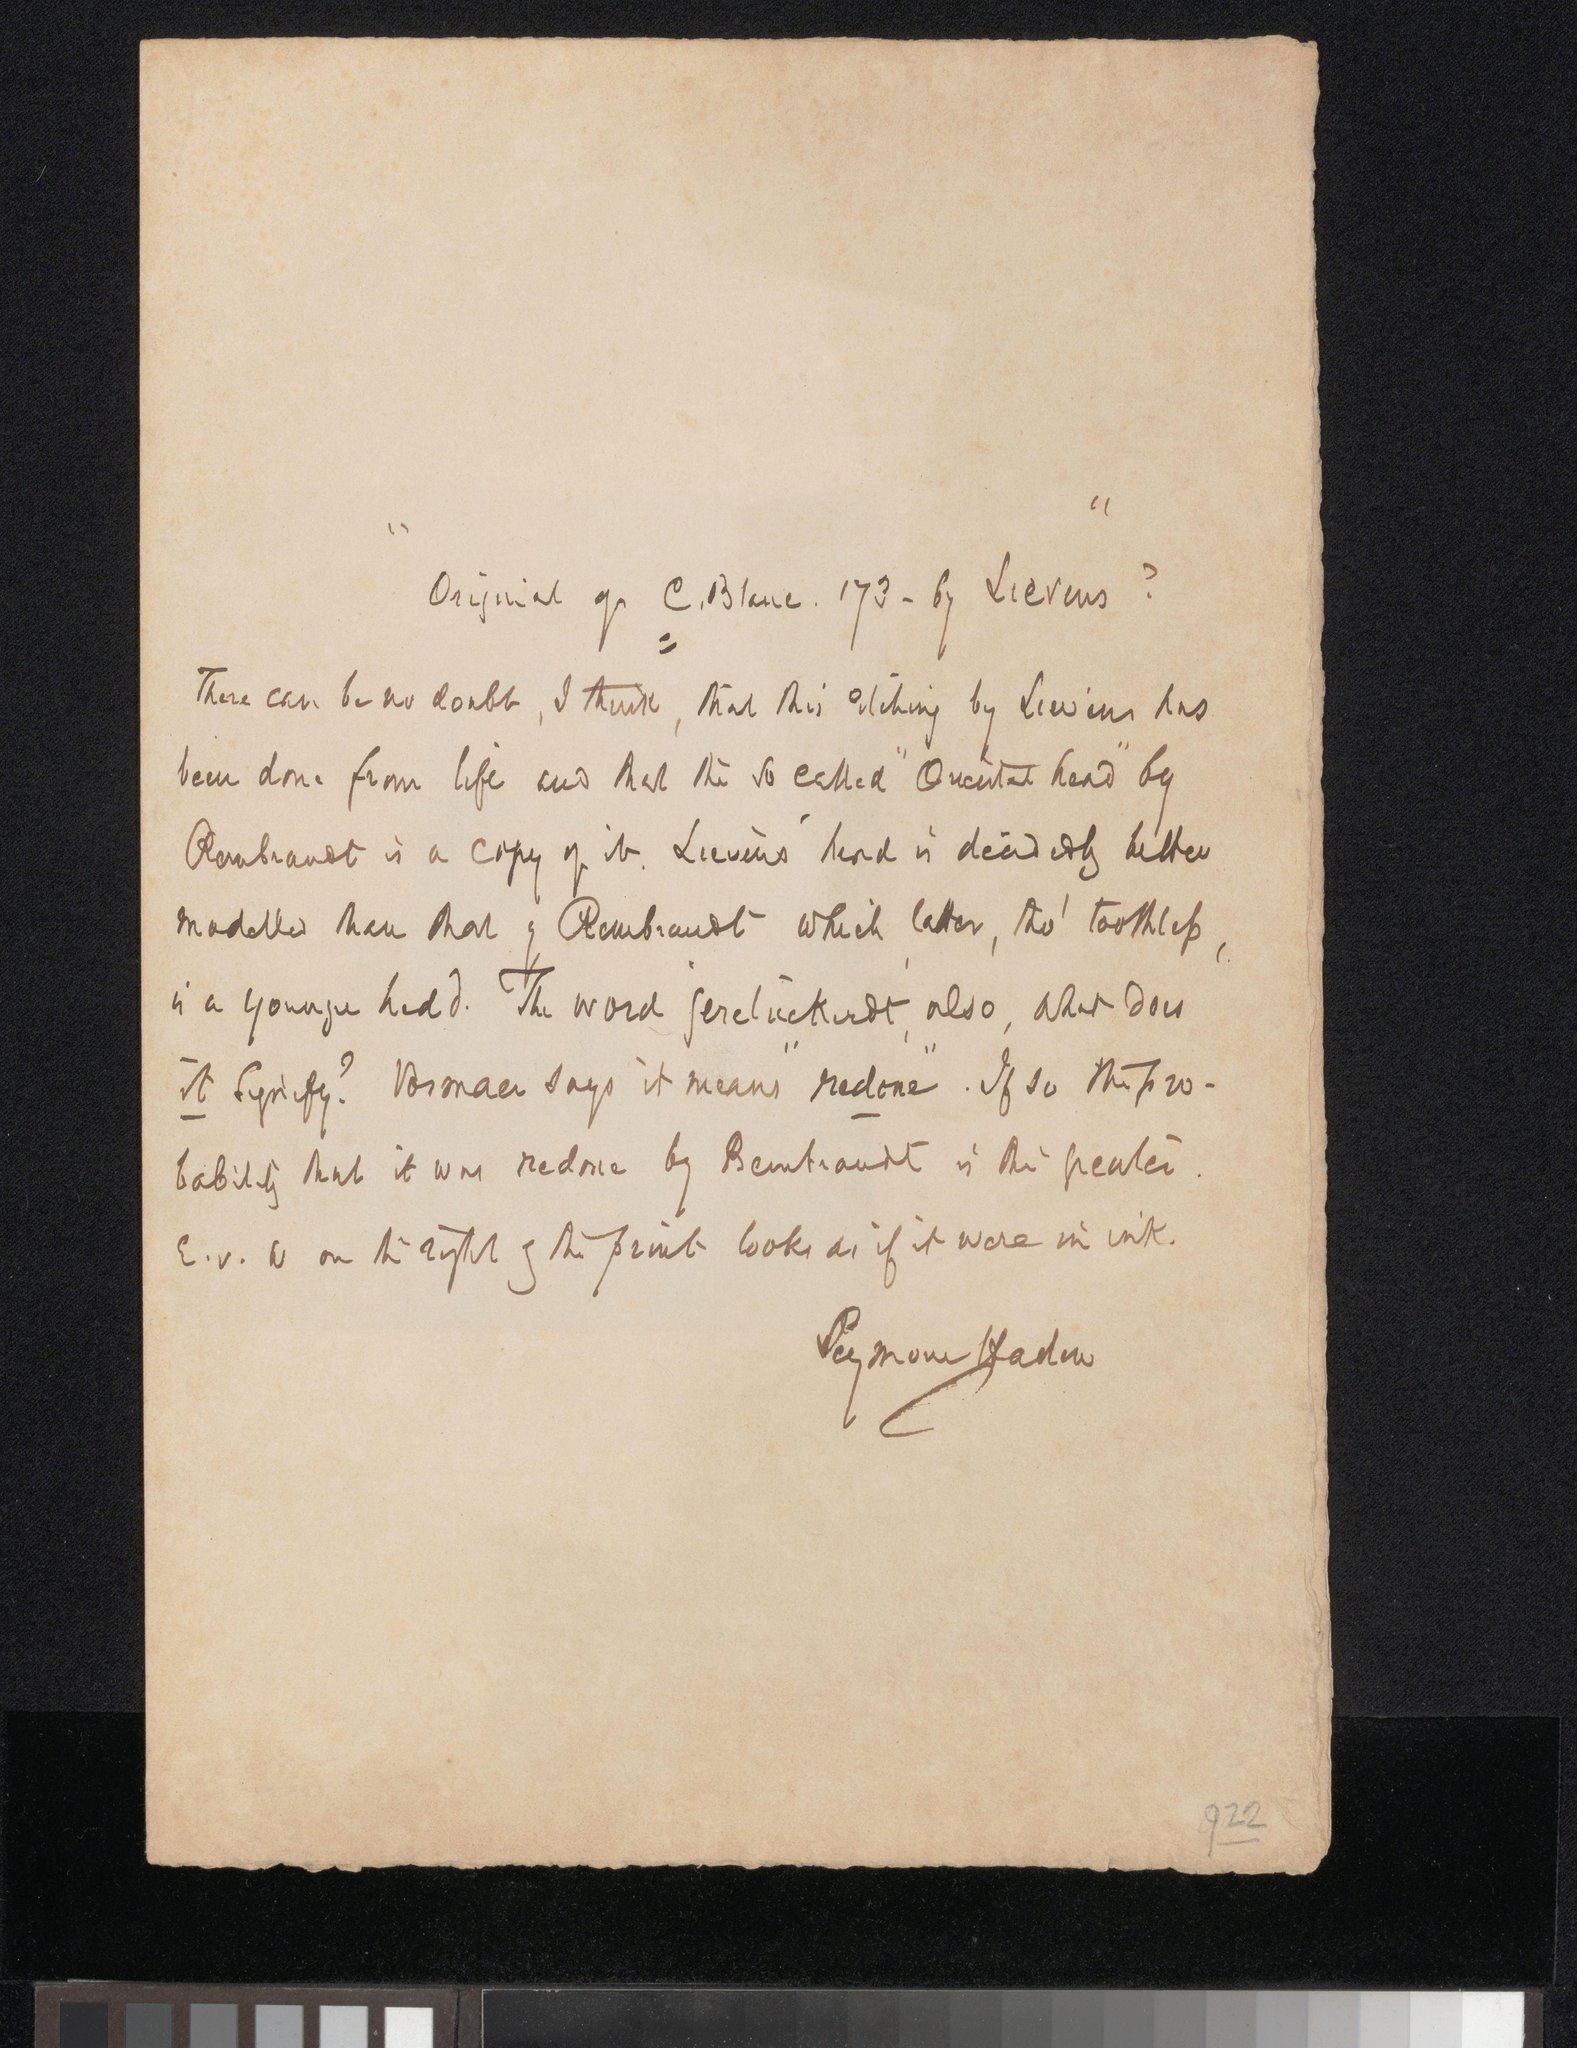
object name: aantekening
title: Aantekening betreffende een ets van Jan Lievens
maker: francis seymour-haden (sir)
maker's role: print maker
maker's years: 1818-1910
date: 1828-1910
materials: ink, paper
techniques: pen, writing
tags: rembrandt van rijn, leiden, painter, draughtsman, jan lievens, the graphic arts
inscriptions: watermark